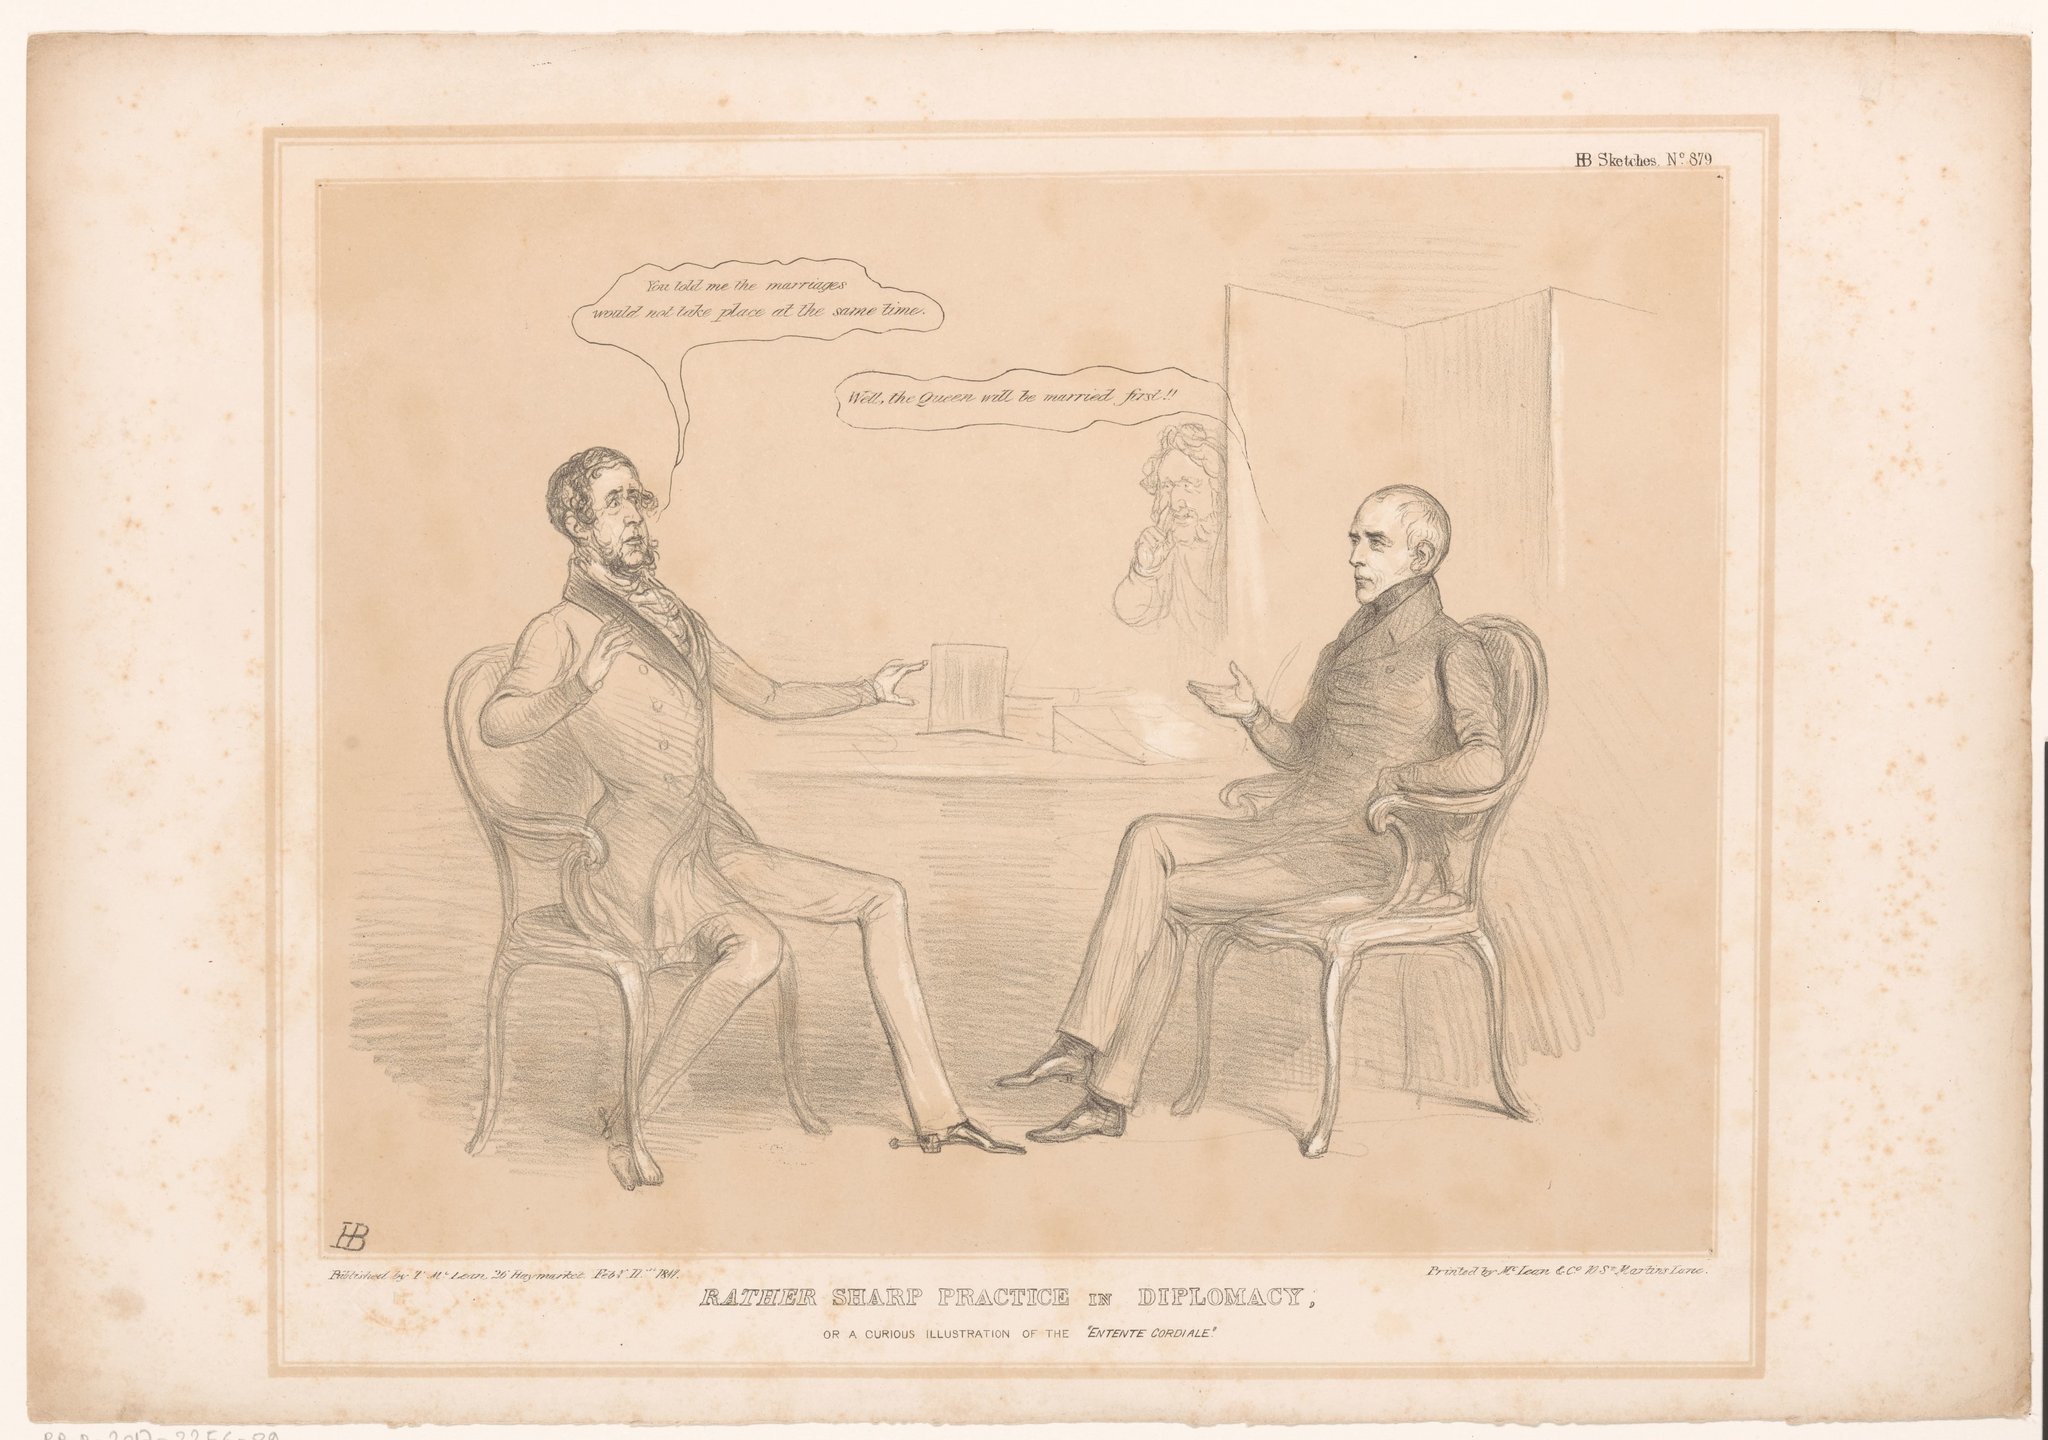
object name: print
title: Spotprent op koninklijke huwelijken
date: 1847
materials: paper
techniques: tone lithography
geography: london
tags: politician, paris, lodewijk filips i (koning van frankrijk), political caricatures and satires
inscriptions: stamp: ‘HB Subscribers Copy’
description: Spotprent uit 1847 waarin de Franse premier François Guizot de Spaanse huwelijken aankondigt aan een verschrikt kijkende Lord Normanby. Achter een kamerscherm luistert de Franse koning Lodewijk Filips I mee. Uitgegeven als nr. 879 in de serie HB Sketches.